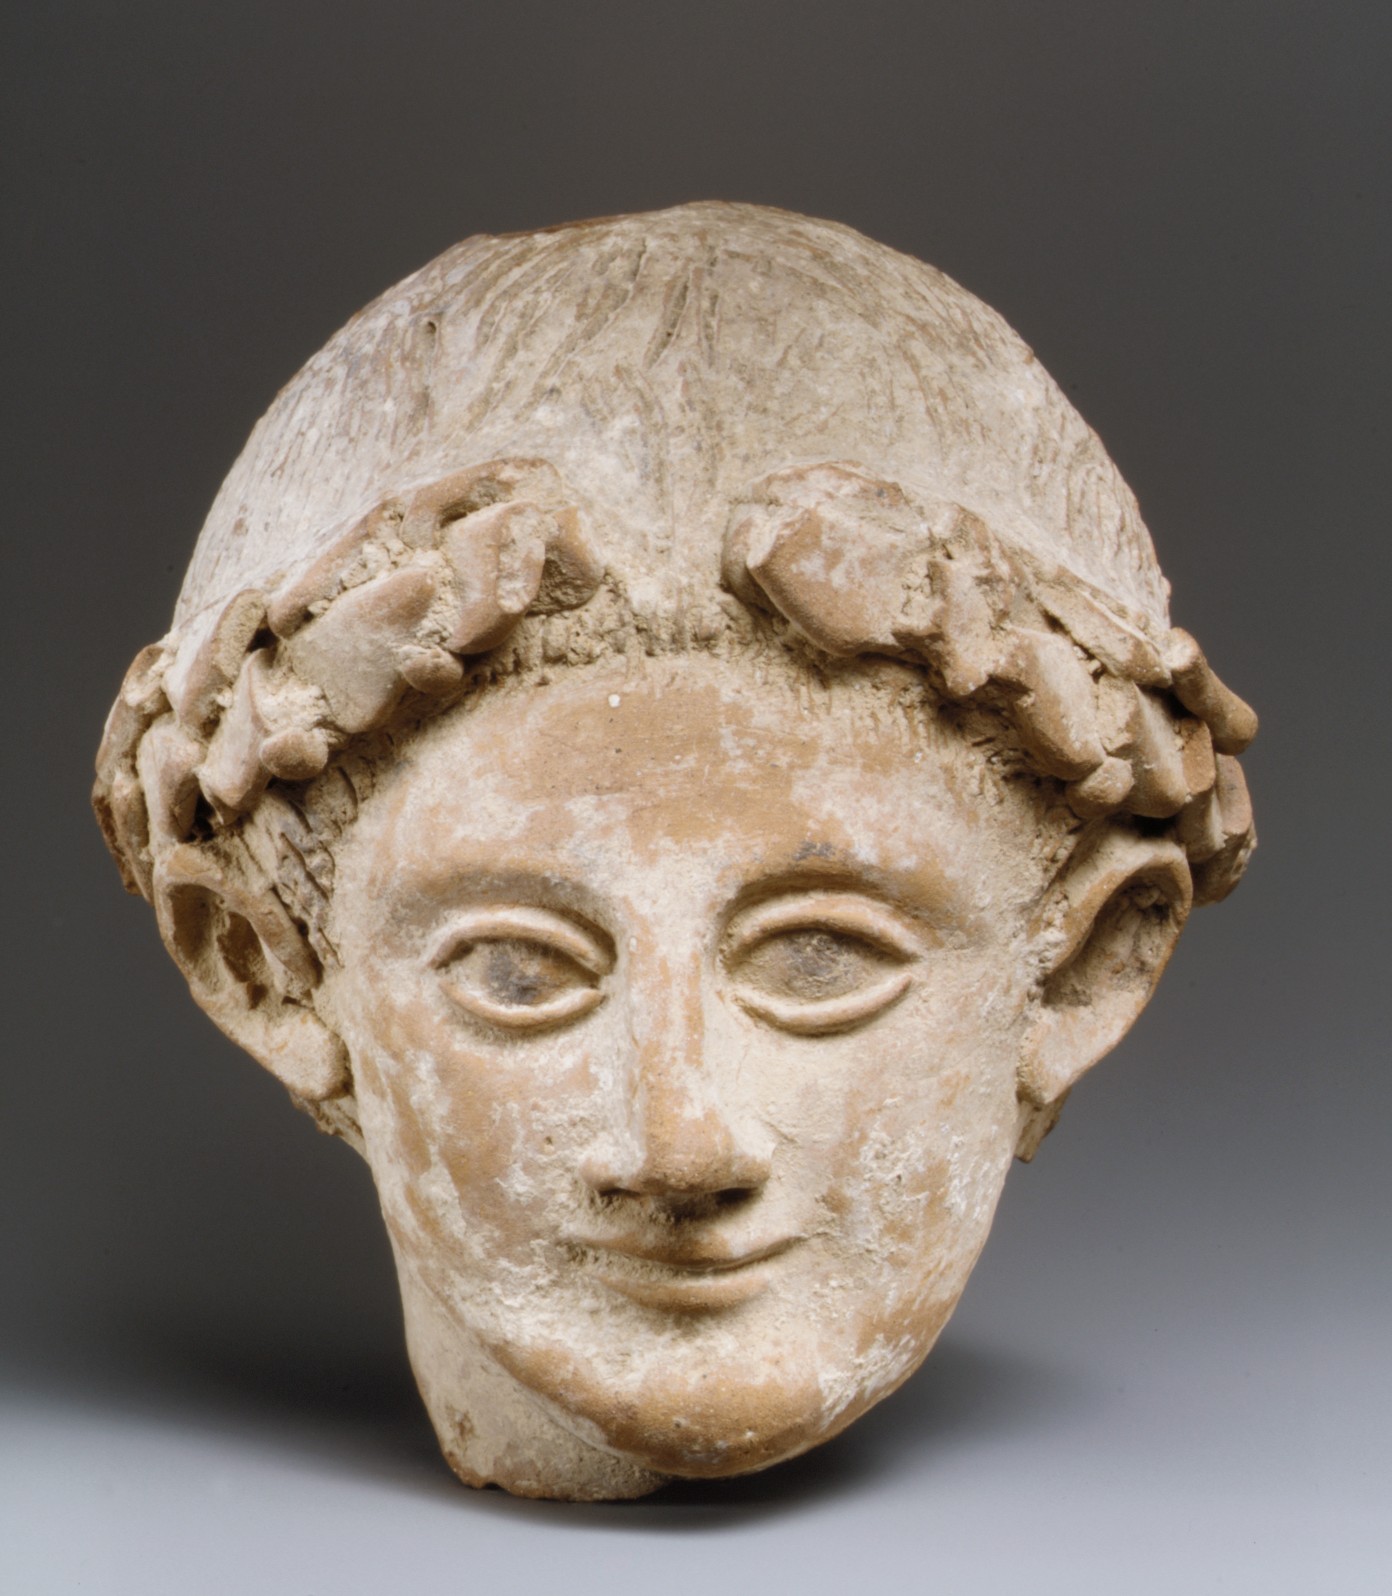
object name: head of a boy with wreath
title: Terracotta head of a wreathed youth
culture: cypriot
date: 300-268 BCE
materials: terracotta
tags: heads,wreaths